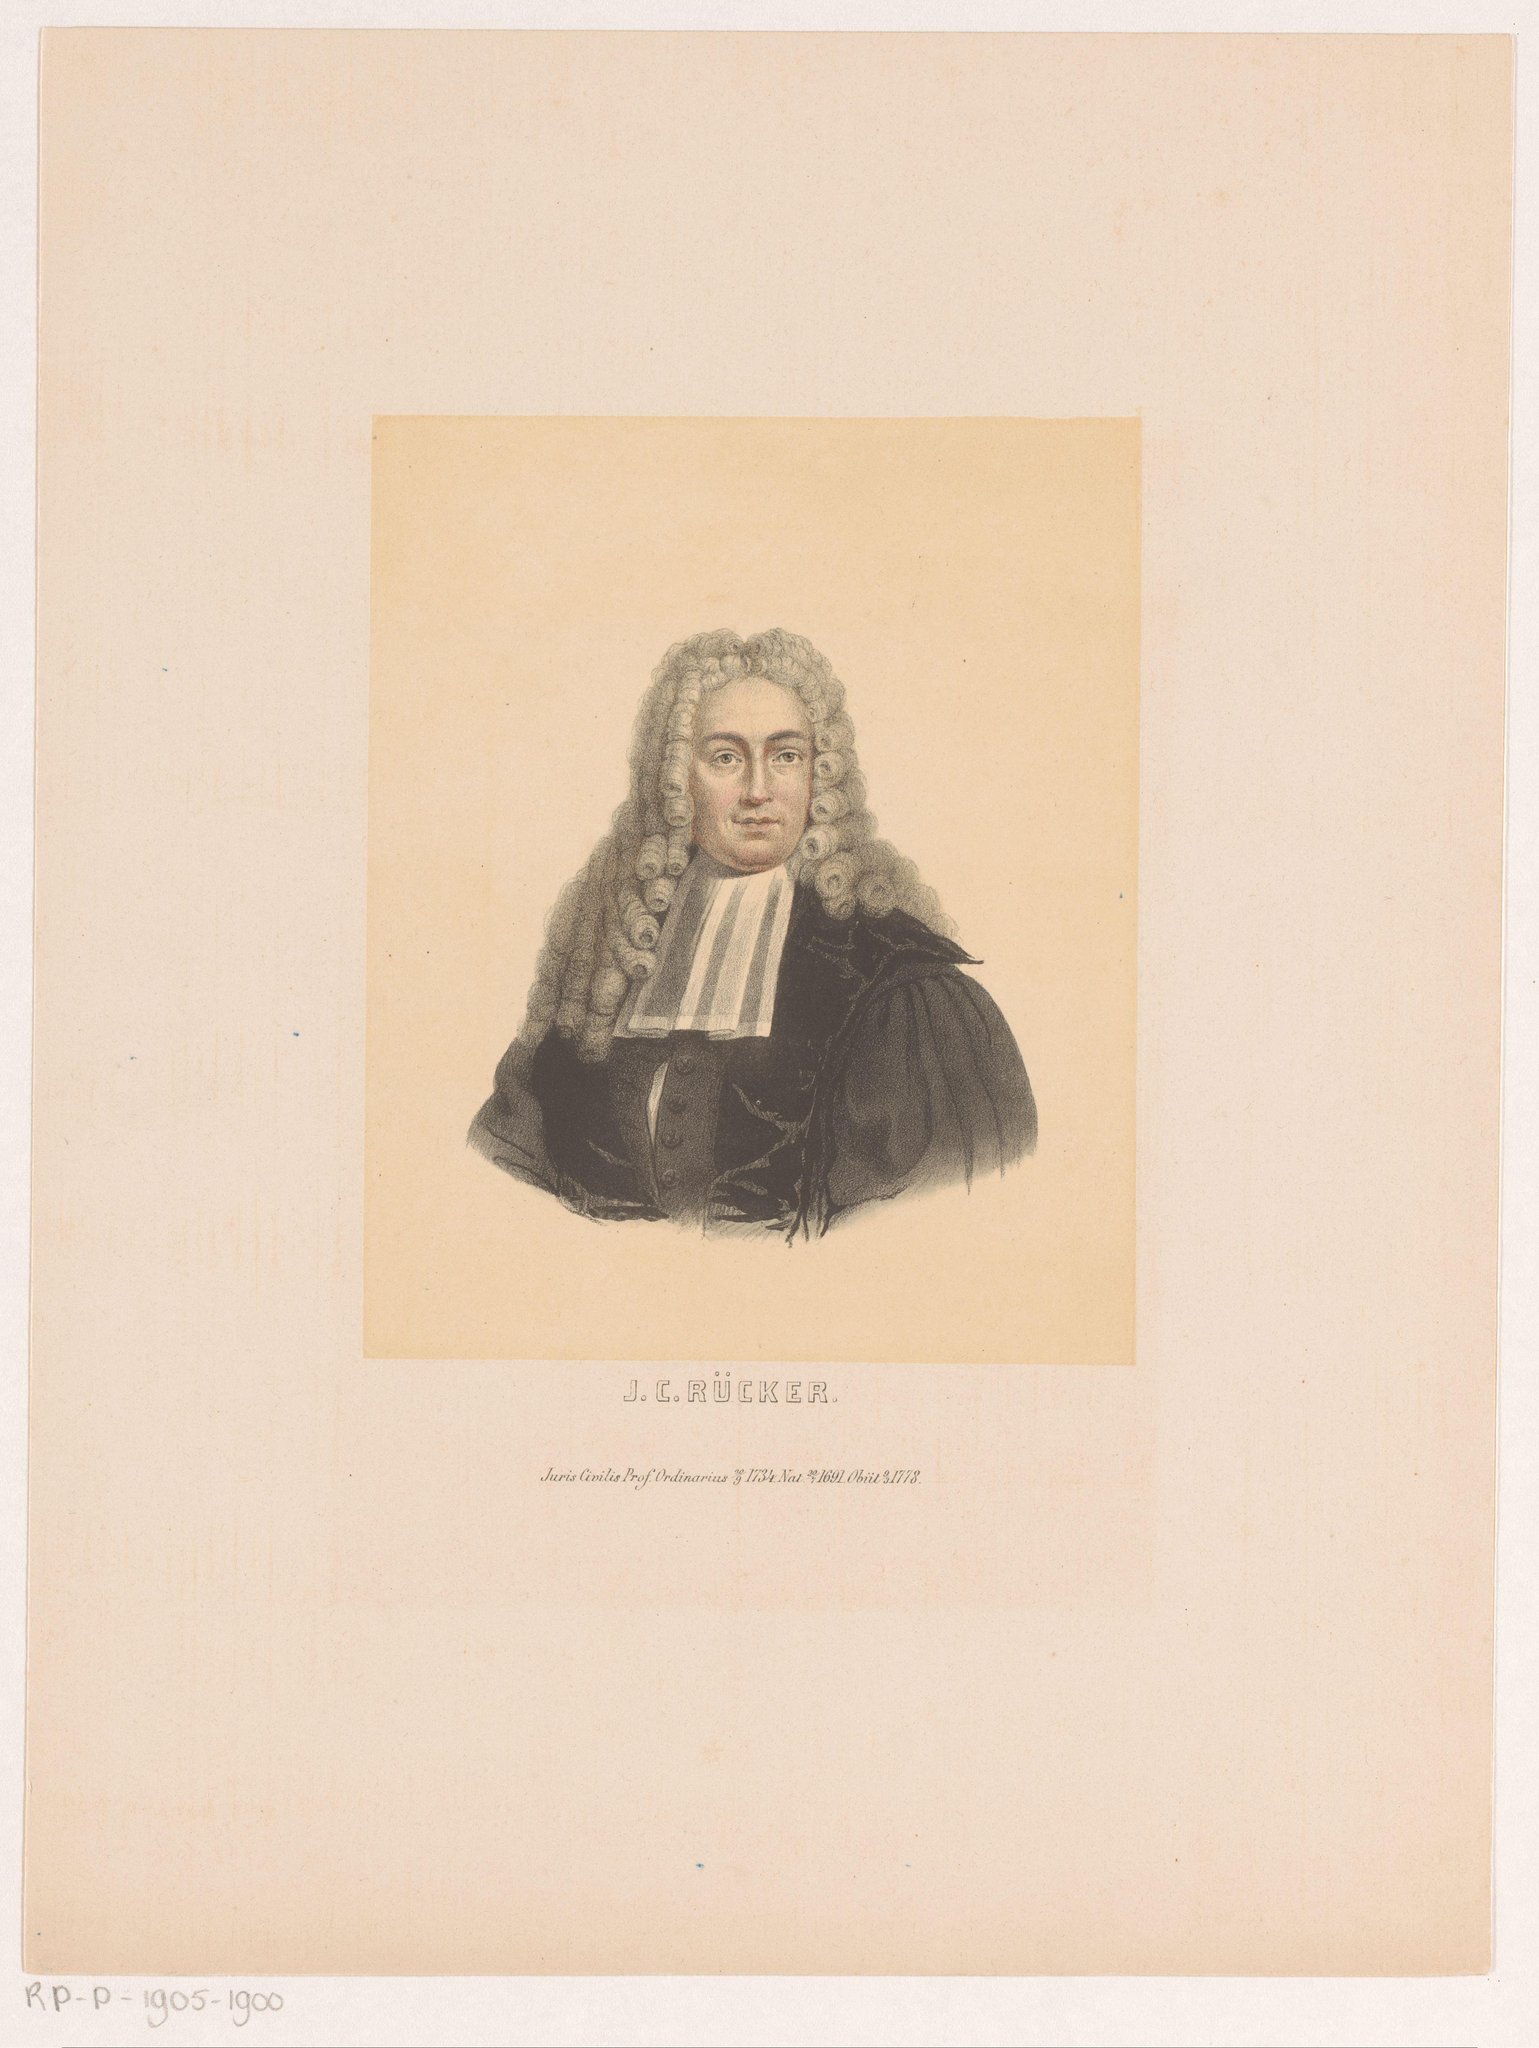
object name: print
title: J.C. Rücker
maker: leendert springer (i)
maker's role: draughtsman, painter, print maker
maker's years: 1789-1871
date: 1850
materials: paper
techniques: lithograph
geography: leiden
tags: historical persons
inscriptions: collector's mark: Lugt 2228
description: Prent uit: Springer, Leendert. Galerij van hoogleeraren aan de Hoogeschool te Leijden, naar de oorspronkelijke afbeeldsels op de Senaat-zaal aldaar berustende. Leiden: Springer, Leendert., s.a. [circa 1850].